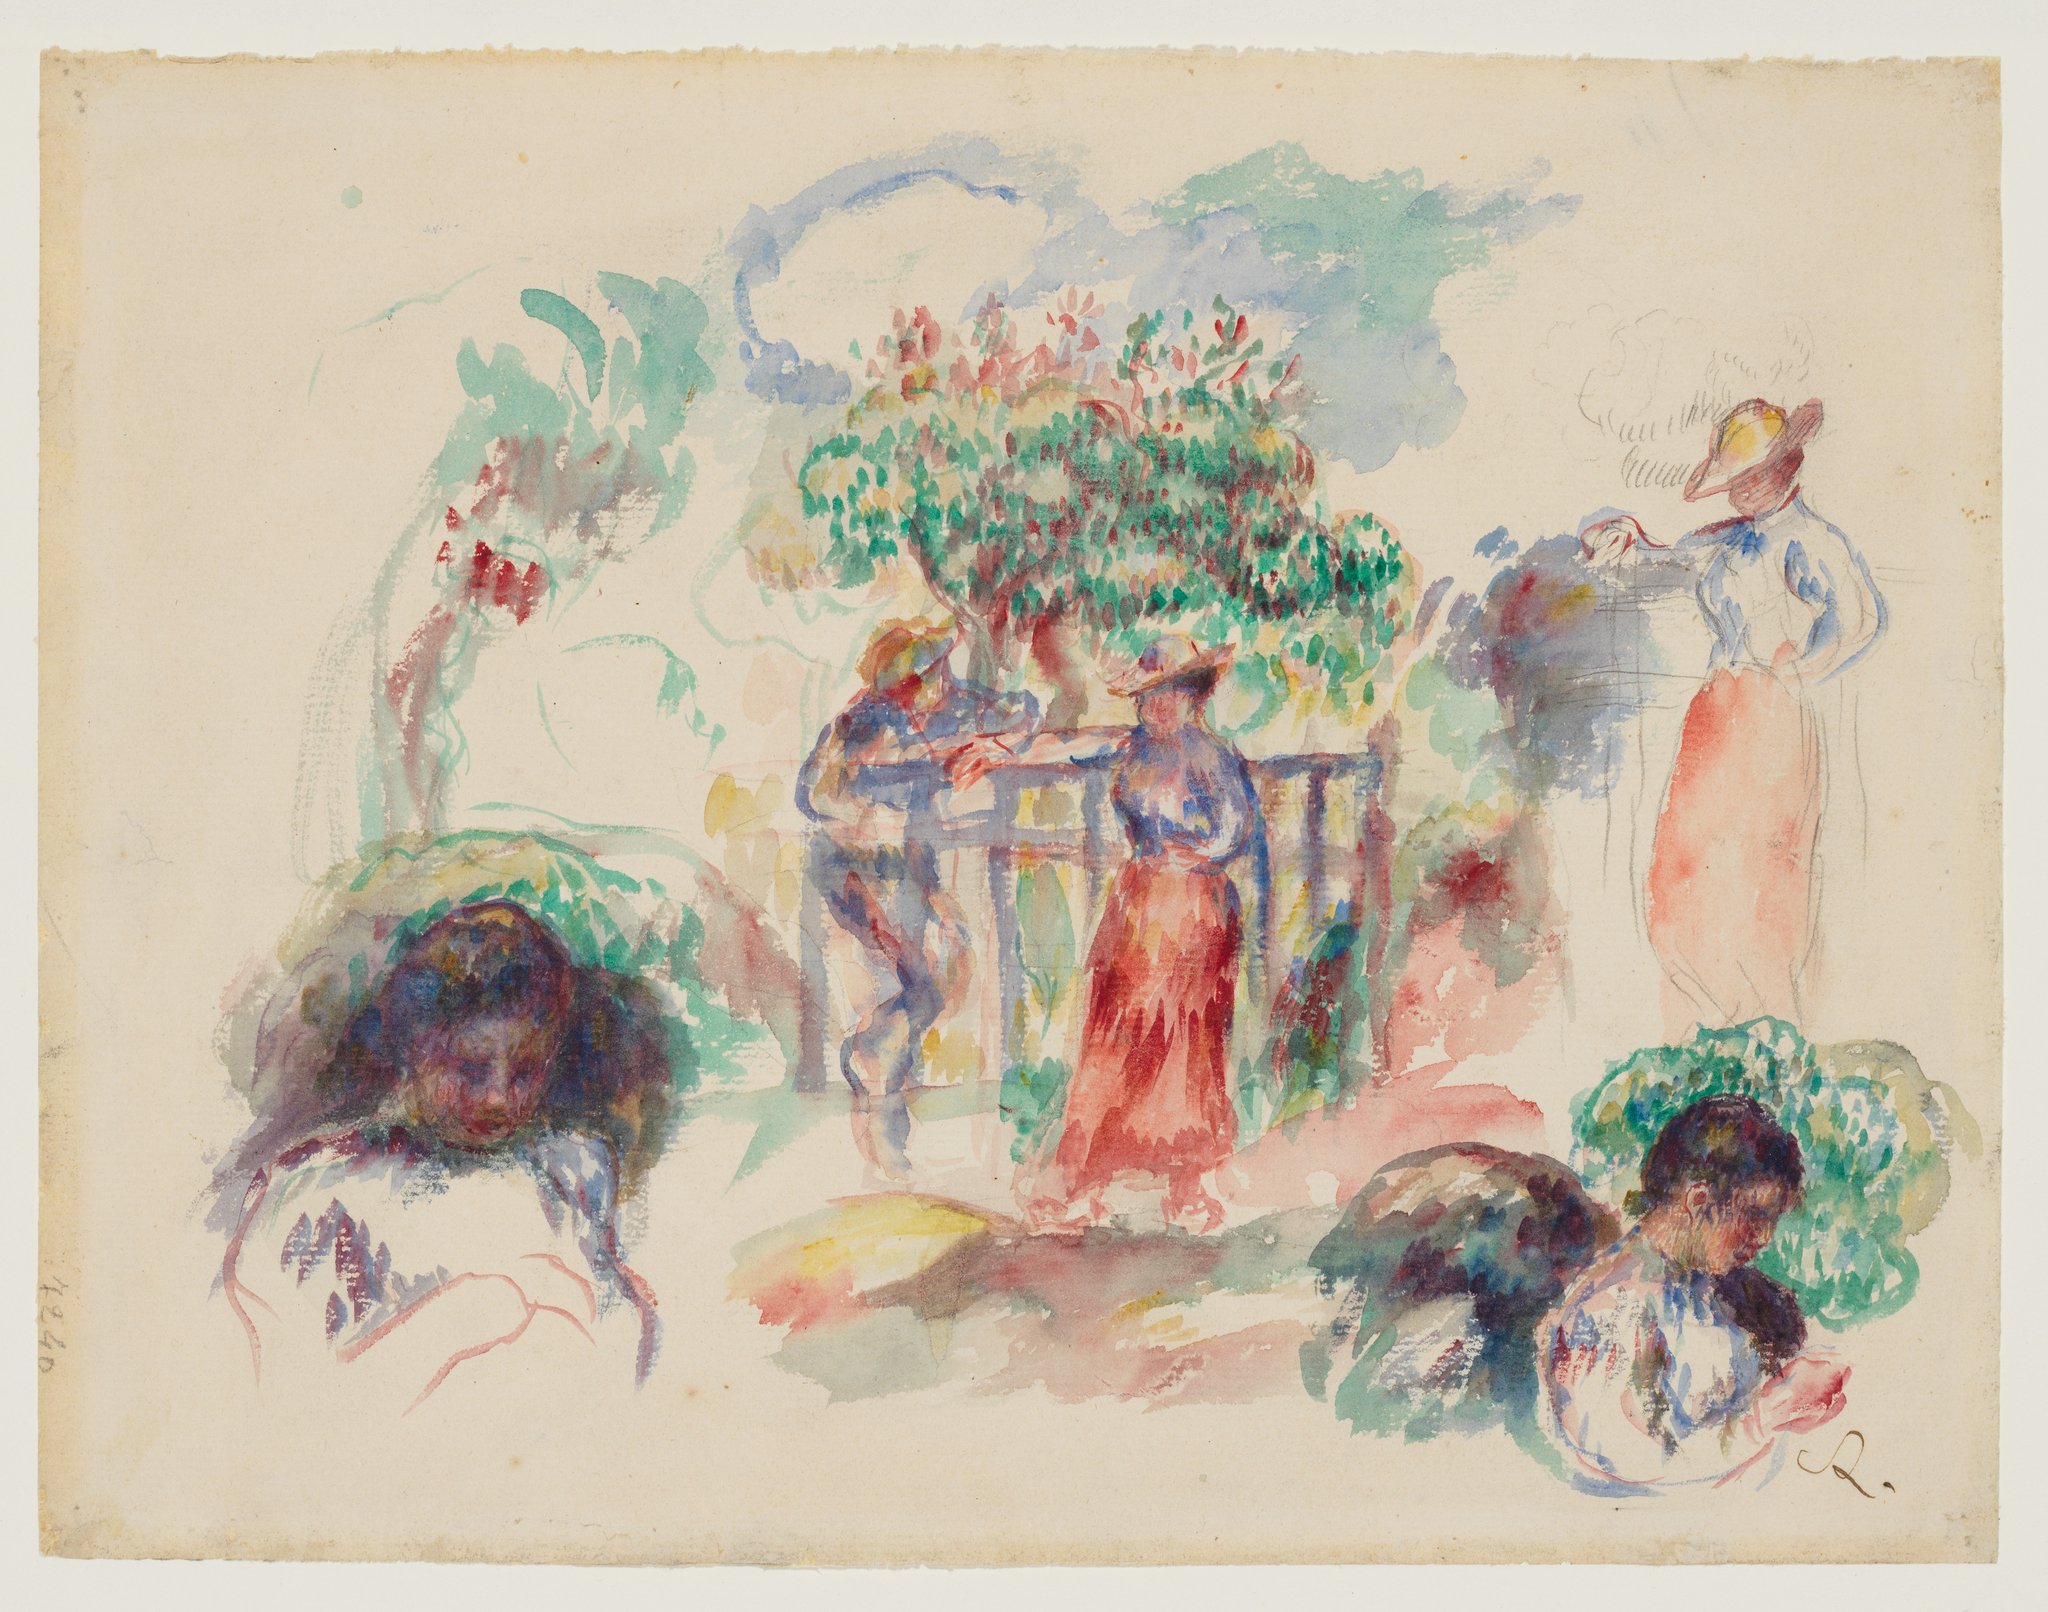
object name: drawing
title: Figures under a Tree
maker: pierre auguste renoir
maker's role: artist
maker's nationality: french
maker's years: 1841-1919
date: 1880-1882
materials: graphite, paper, watercolor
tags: men,women